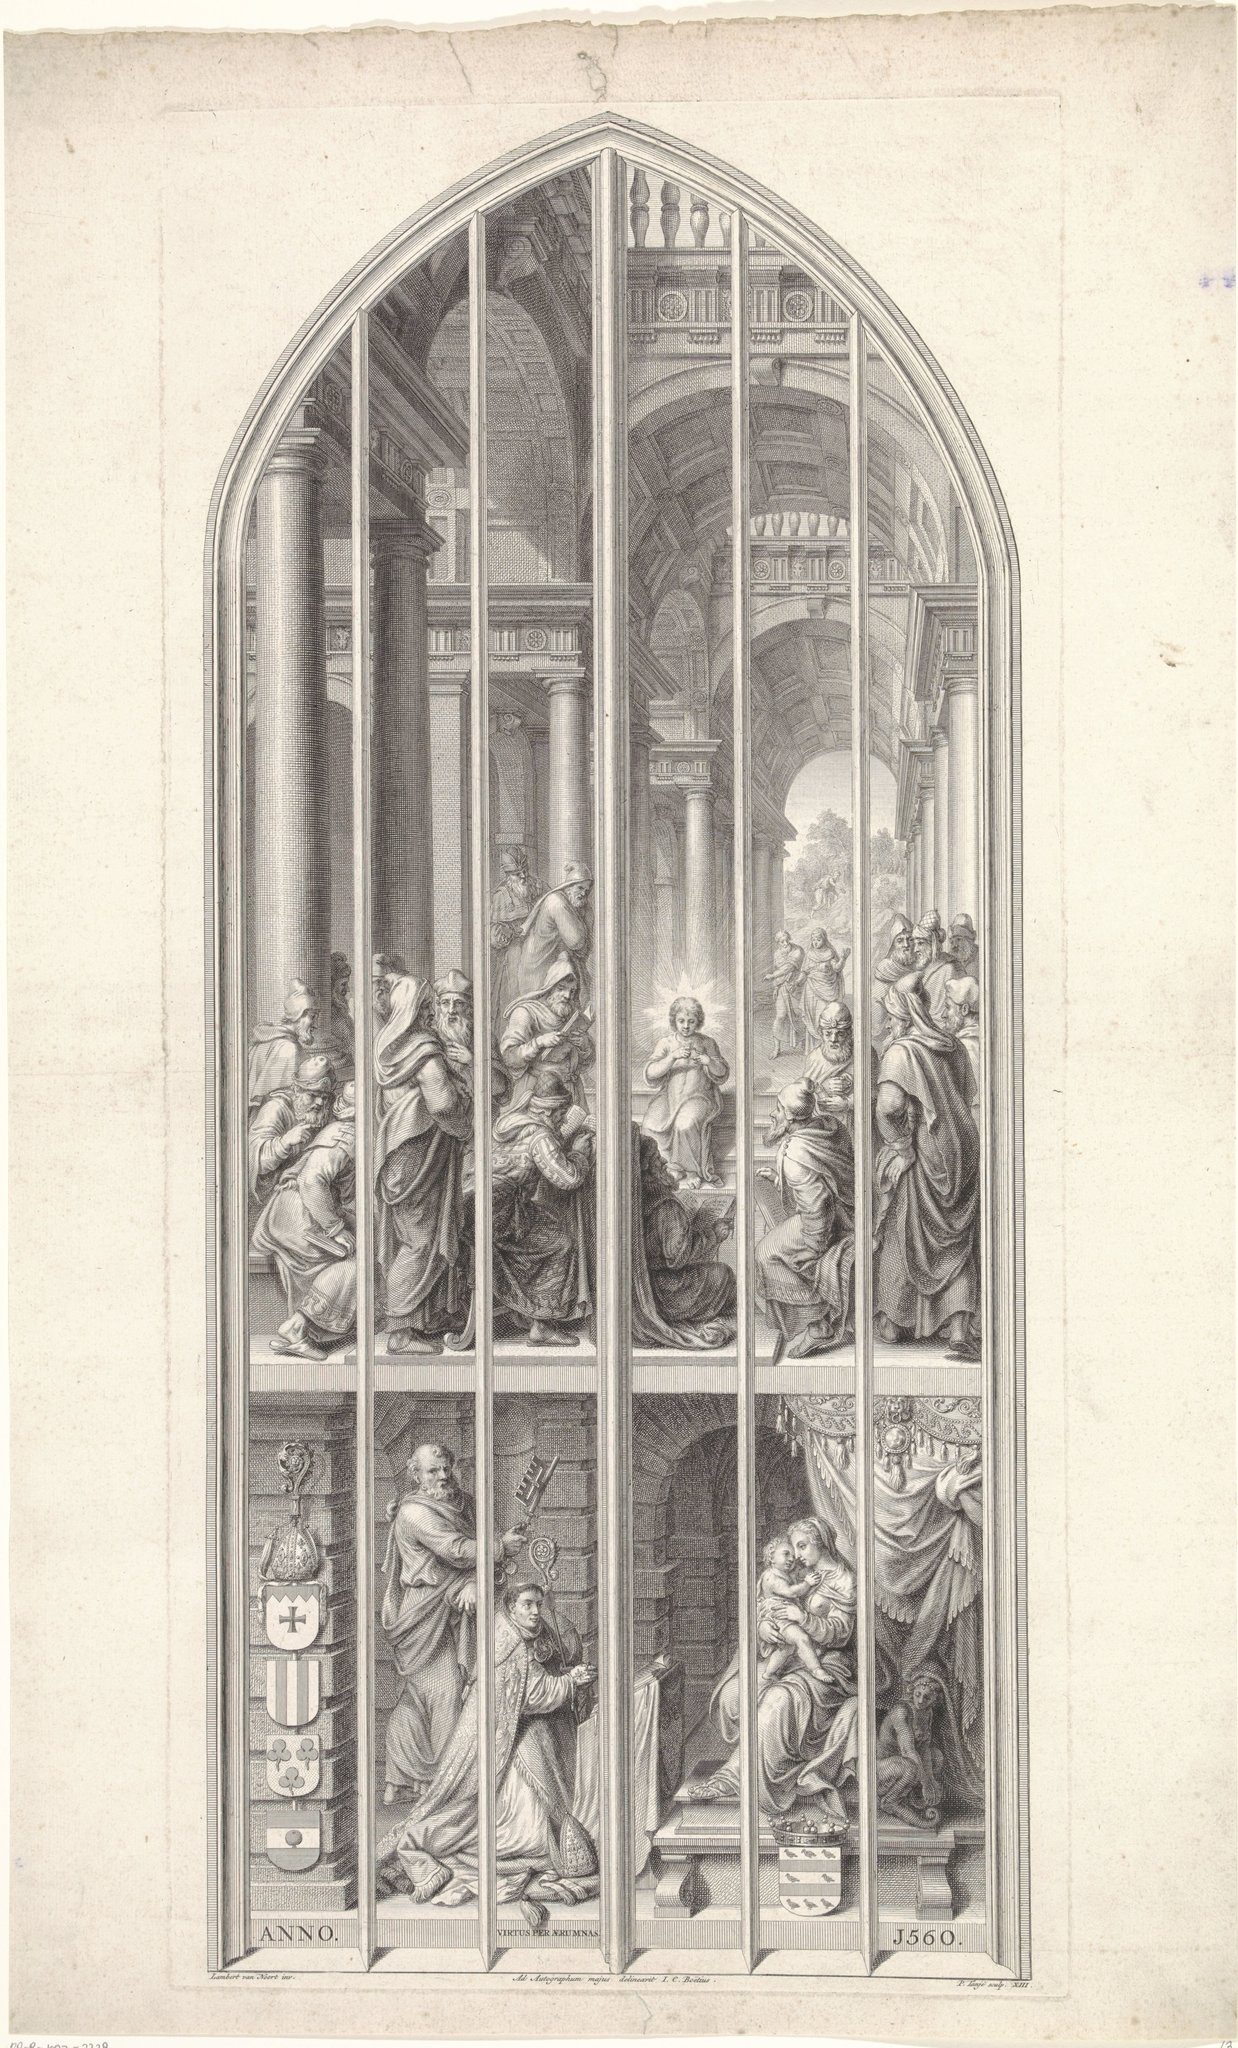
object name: print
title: Goudse glazen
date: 1738-1754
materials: paper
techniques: engraving, etching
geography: amsterdam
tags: the apostle peter, first bishop of rome; possible attributes: book, cock, (upturned) cross, (triple) crozier, fish, key, scroll, ship, tiara (+ donor(s), supplicant(s), whether or not with patron saint(s)), christ's dispute with the doctors in the temple; he counts his arguments on his fingers, church-window, e.g. rose-window, mary sitting or enthroned, the christ-child in front of her in her lap (or in front of her bosom)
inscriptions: collector's mark: Lugt 2228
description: Het dertiende glasraam in de Sint-Janskerk te Gouda met de voorstelling van de twaalfjarige Christus in de tempel tussen de schriftgeleerden. Christus telt zijn argumenten op zijn vingers, terwijl de schriftgeleerden hun boeken bestuderen. Op de achtergrond komen Jozef en Maria aansnellen op zoek naar hun zoon. Geheel in de achtergrond trekt Johannes de Doper de woestijn in. In de onderste voorstelling knielt de schenker van het raam, Petrus van Zuyren, voor Maria met het Christuskind. Achter Petrus van Zuyren staat zijn naamheilige Petrus met de sleutel als zijn attribuut.